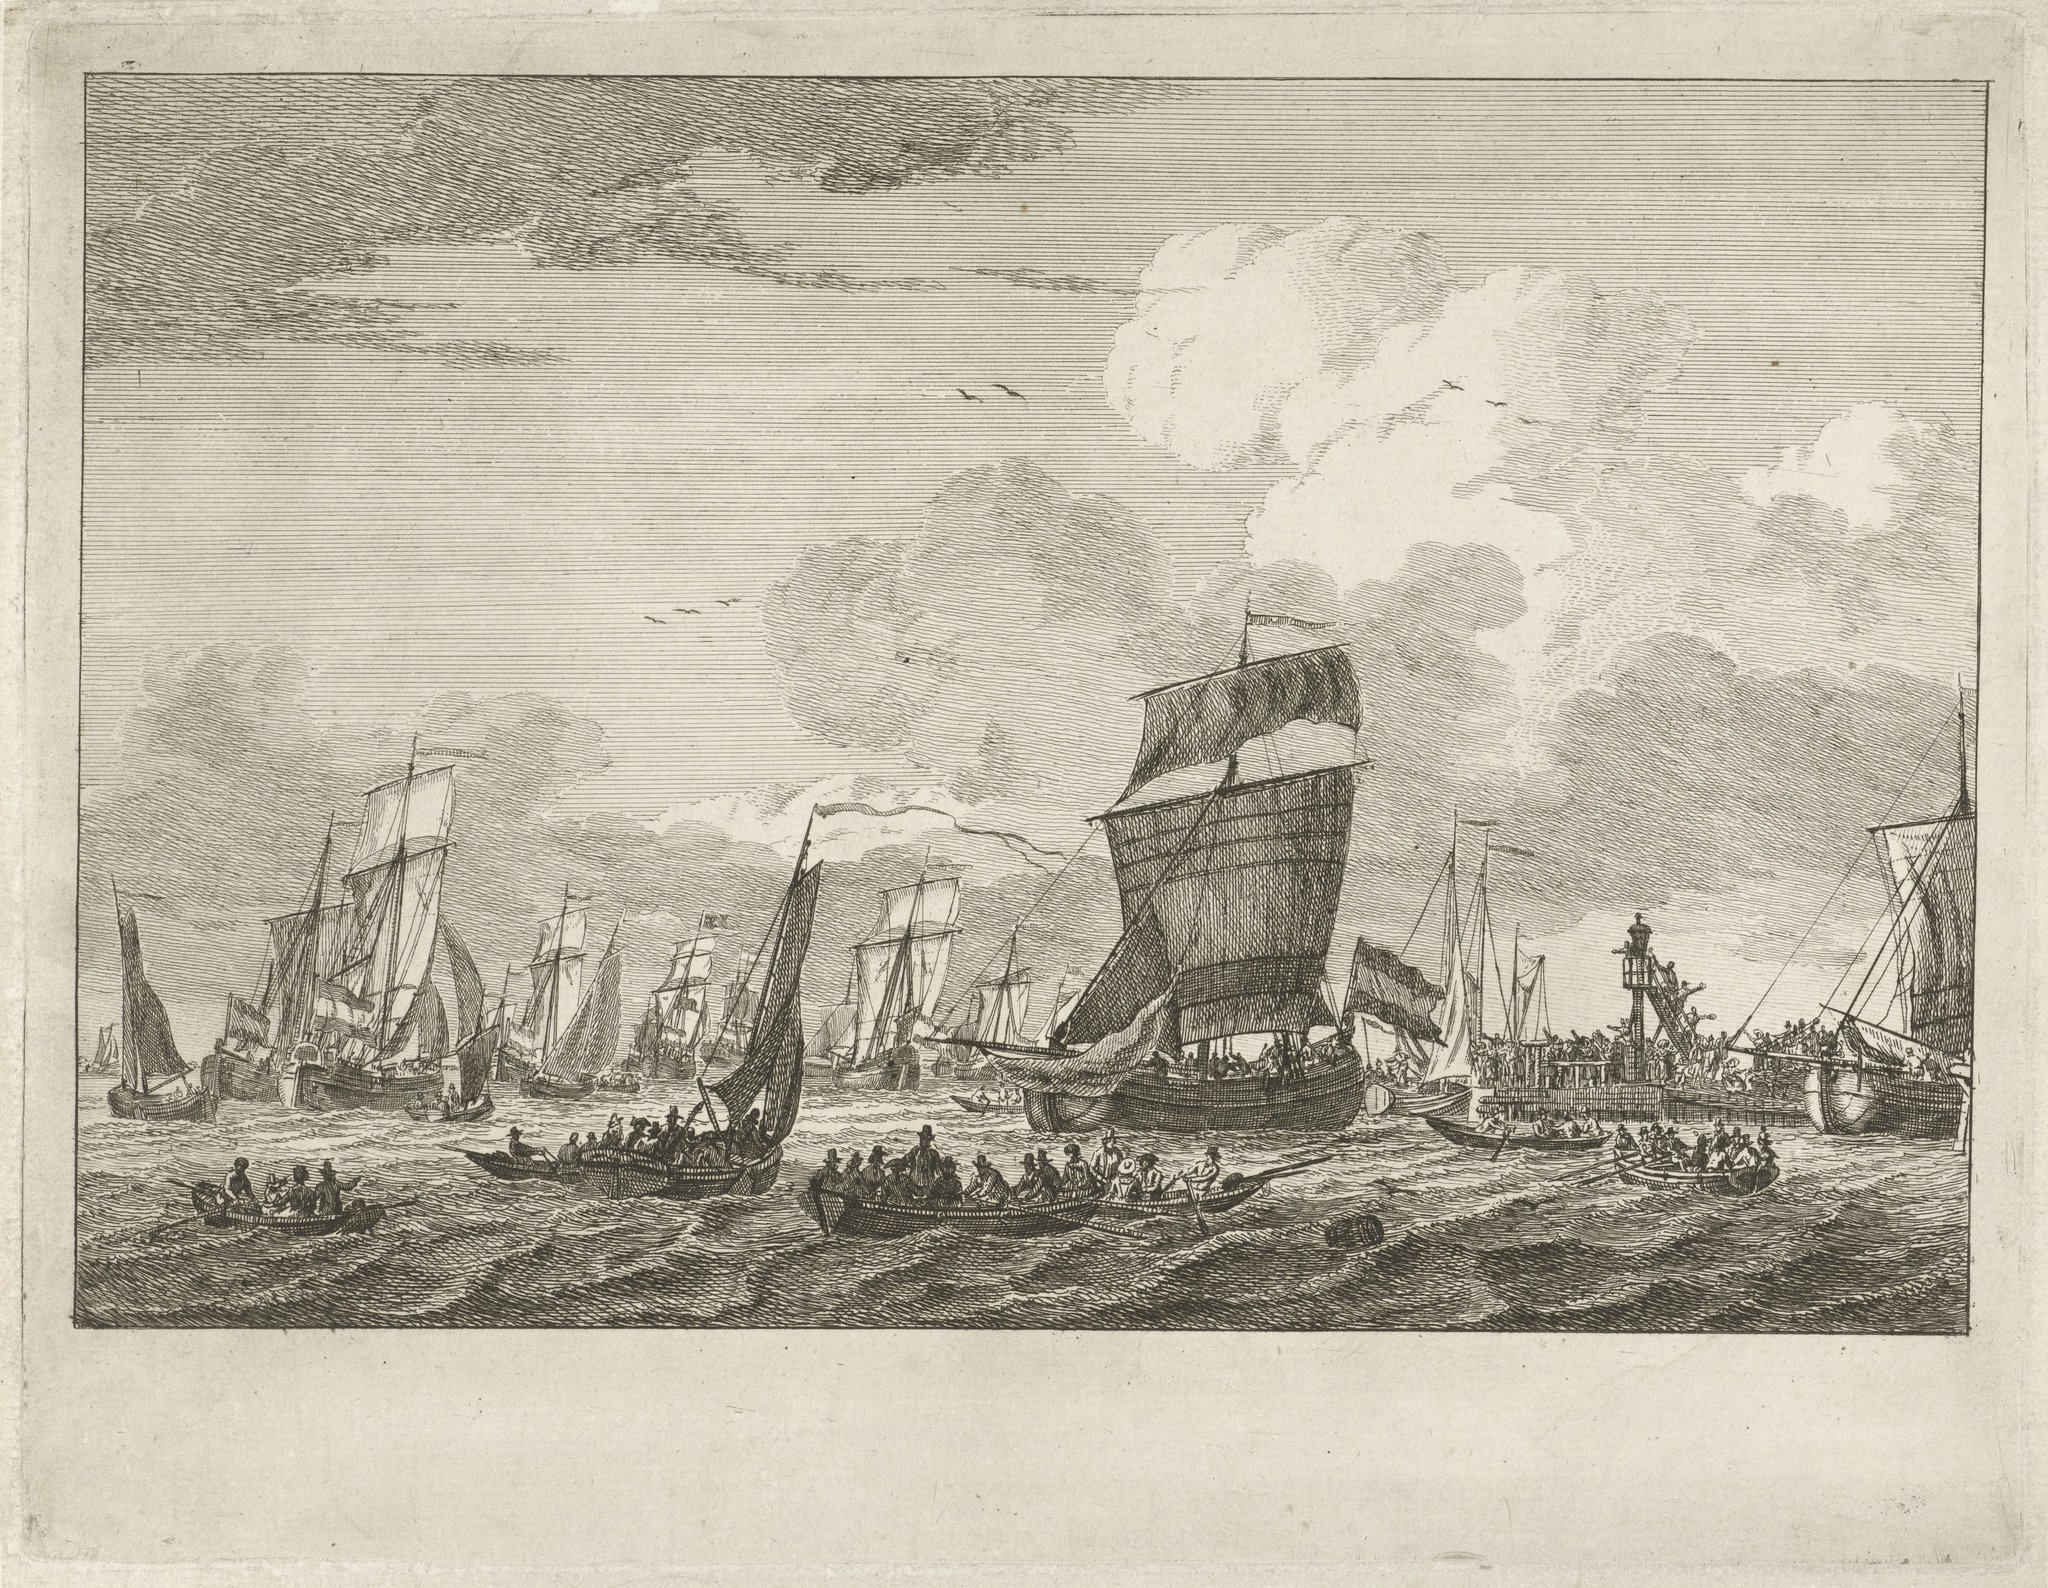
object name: print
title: Uitvarende schepen bij Vlaardingen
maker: gerrit groenewegen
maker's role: draughtsman, print maker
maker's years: 1754-1826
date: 1764-1826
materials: paper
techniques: engraving, etching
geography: rotterdam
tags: sailing-ship, sailing-boat, rowing-boat, canoe, etc.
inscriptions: collector's mark: Lugt 2228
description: Op een overvolle pier in Vlaardingen staan vele mensen naar de uitvarende sloepen, vissersboten en zeilschepen te zwaaien.